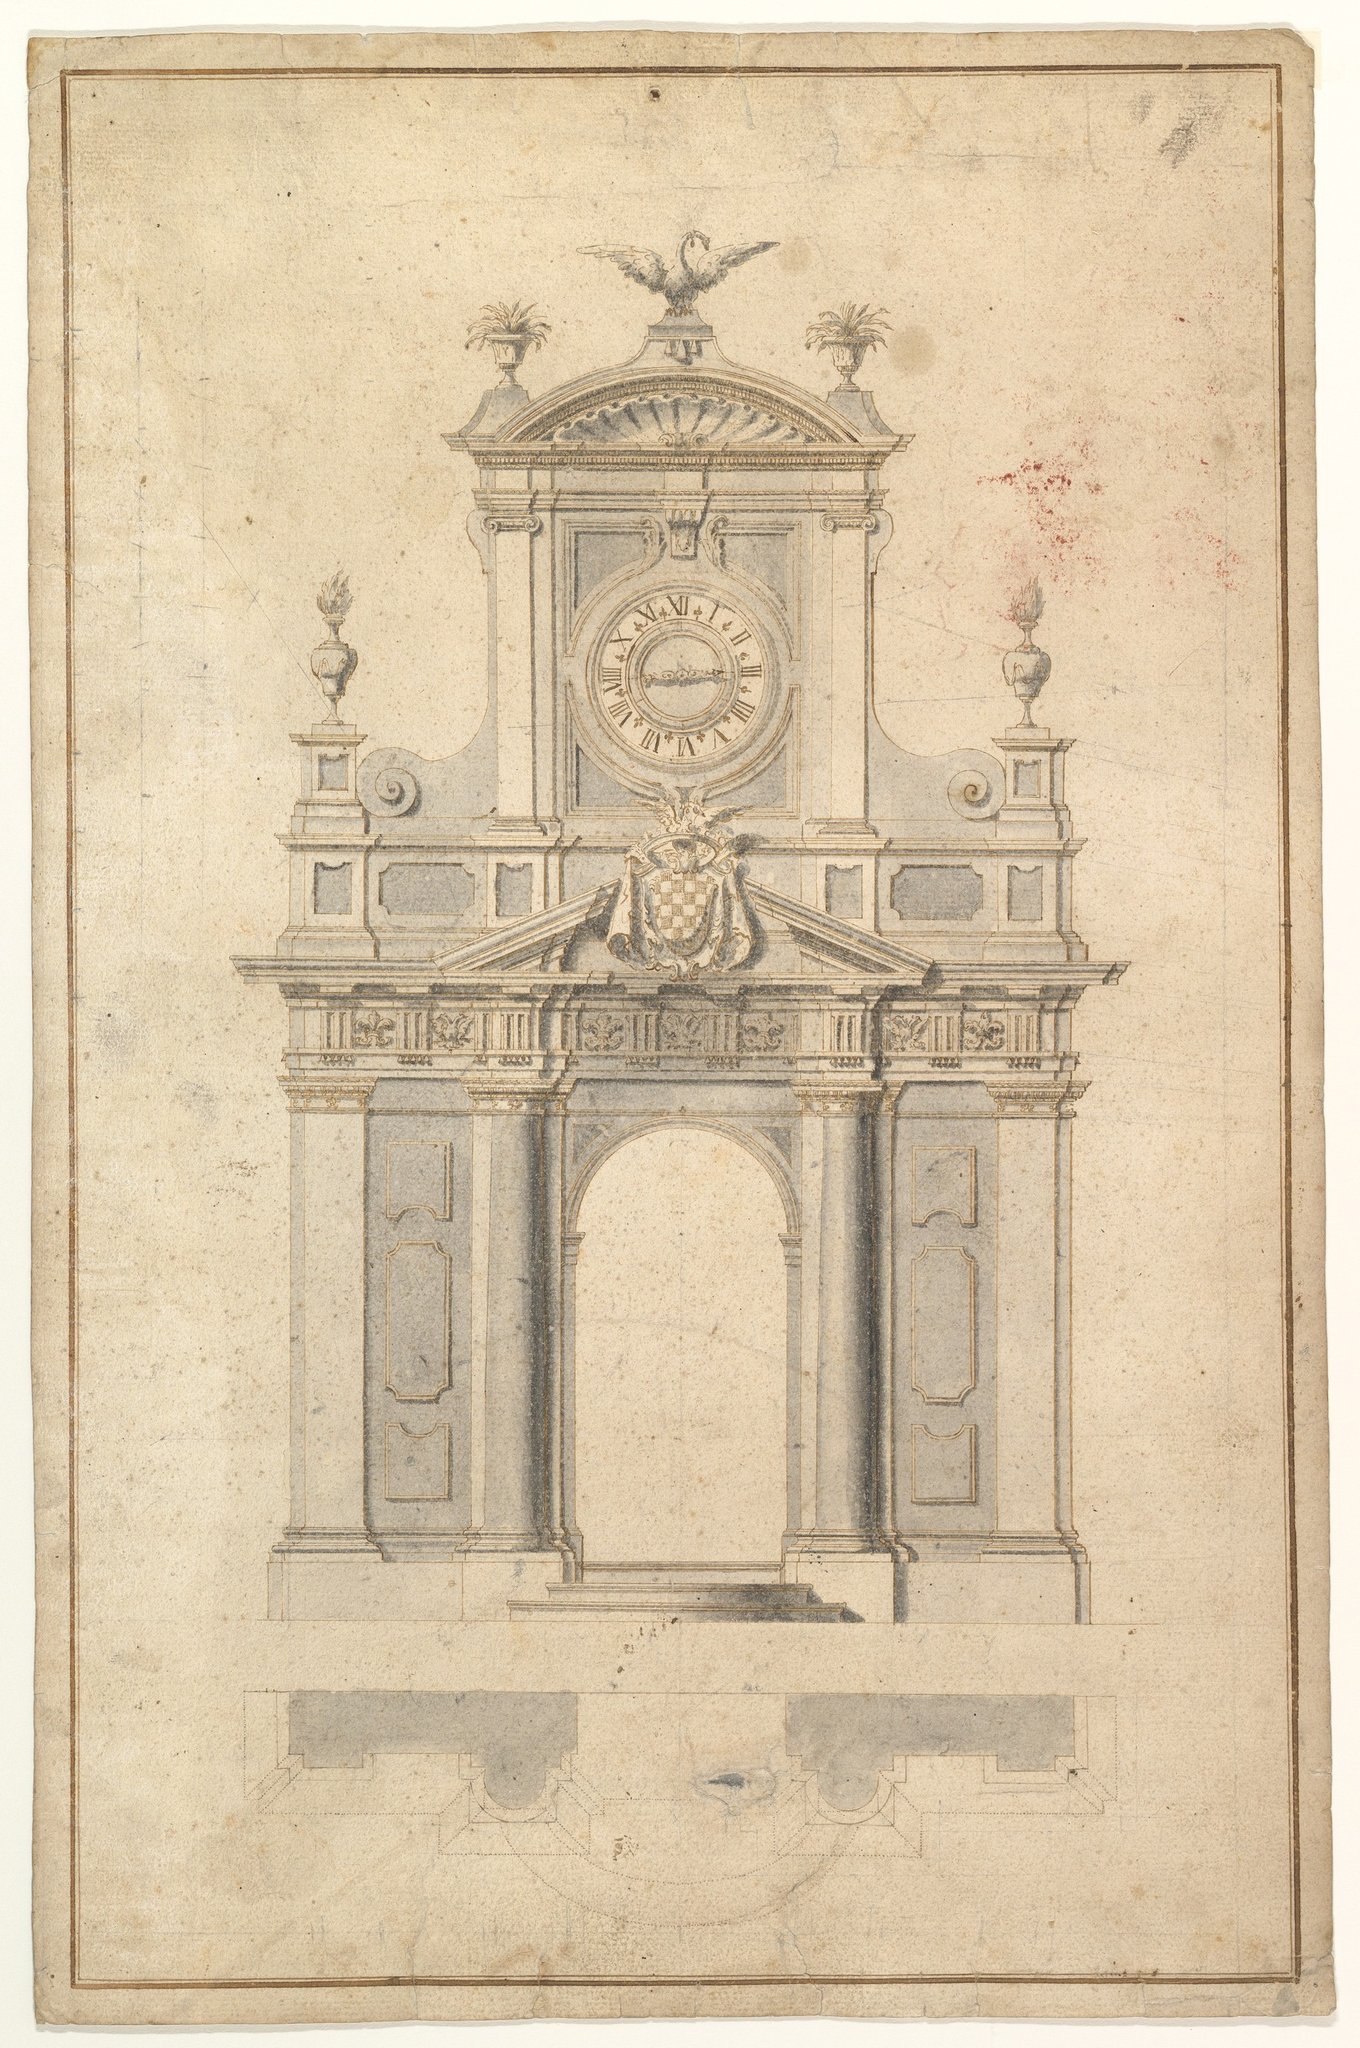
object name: drawing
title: Design for an Entrance Arch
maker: anonymous, italian, 17th or 18th century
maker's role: artist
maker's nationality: italian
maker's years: 1600-1799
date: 1601-1700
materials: ink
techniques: brush, pen, wash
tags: arches,clocks